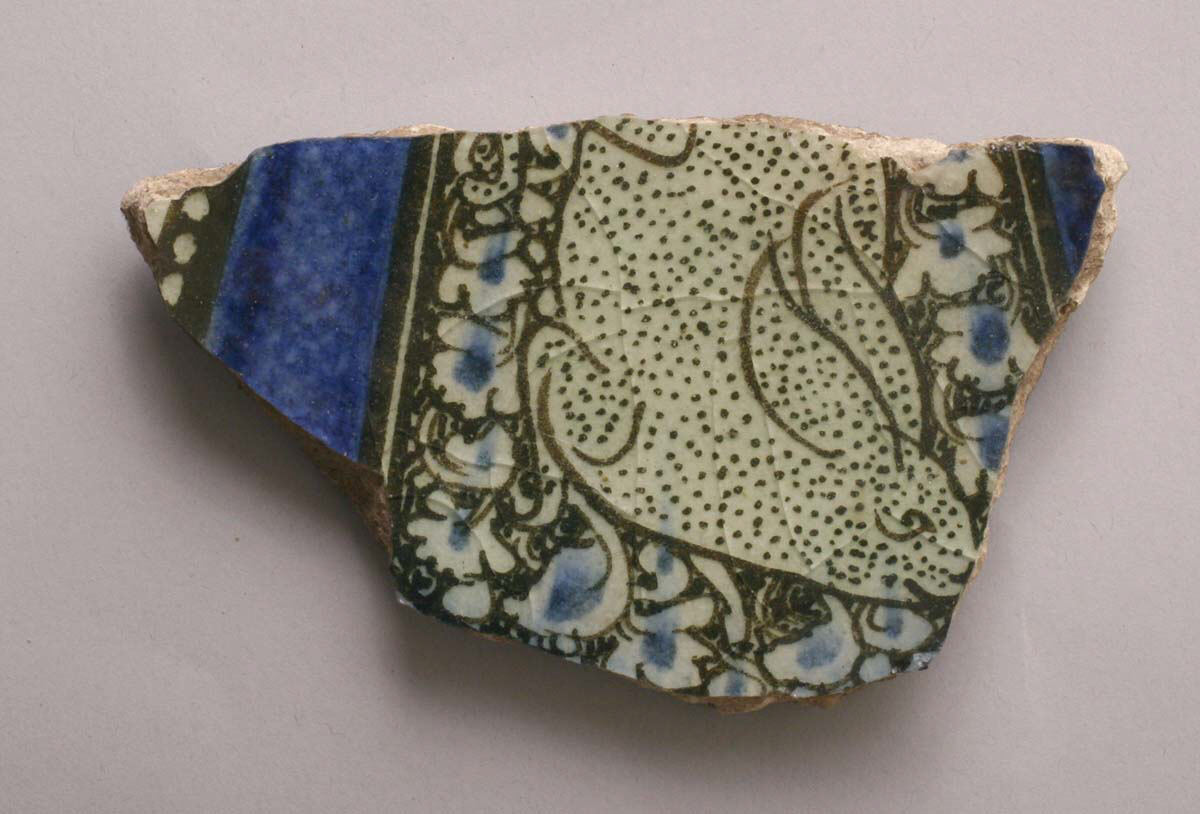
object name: fragment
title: Ceramic Fragment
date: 1301-1400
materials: glaze, stonepaste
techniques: underglaze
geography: syria